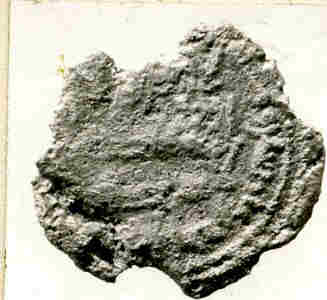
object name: coin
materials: copper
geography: iran